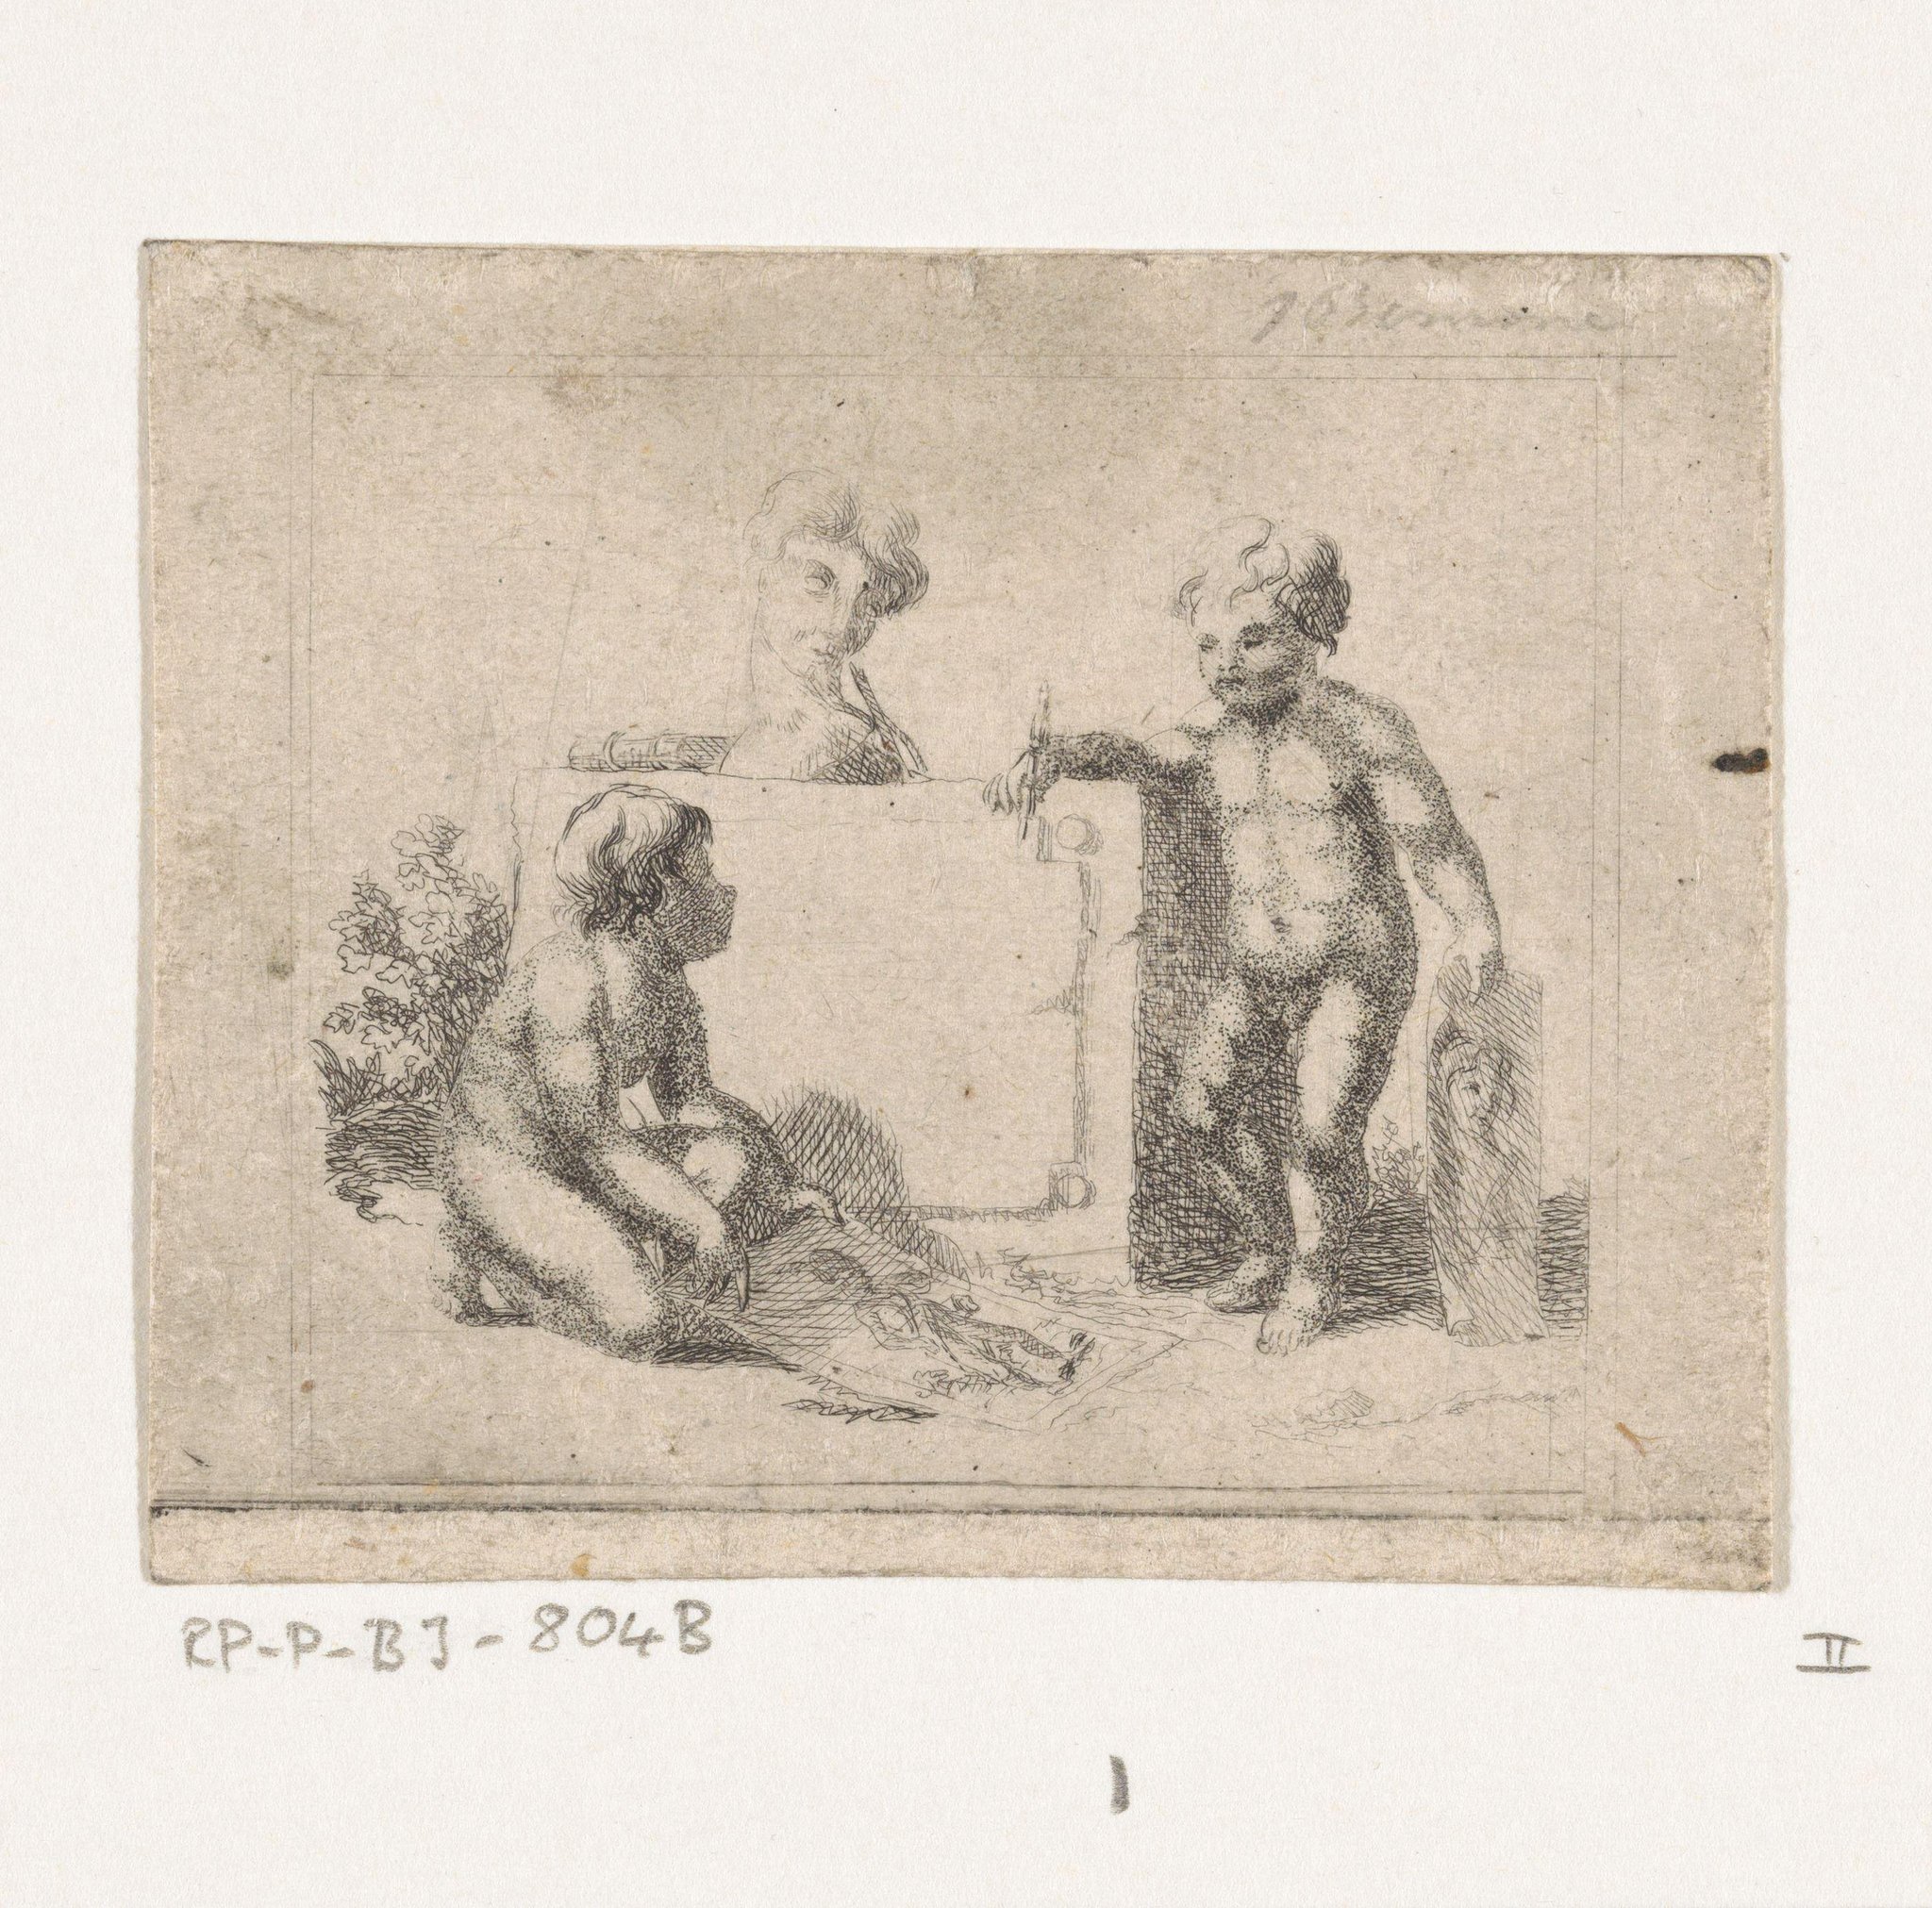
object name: print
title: Drie naakte kinderen bij een steen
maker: joannes bemme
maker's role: print maker, printer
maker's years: 1775-1841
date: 1800-1841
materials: paper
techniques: etching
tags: toddler (male) (+ three persons)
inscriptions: collector's mark: Lugt 2228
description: Drie naakte kinderen bij een steen. De een heeft een pen en een tekening in zijn handen, de ander wijst naar een tekening die op de grond ligt.